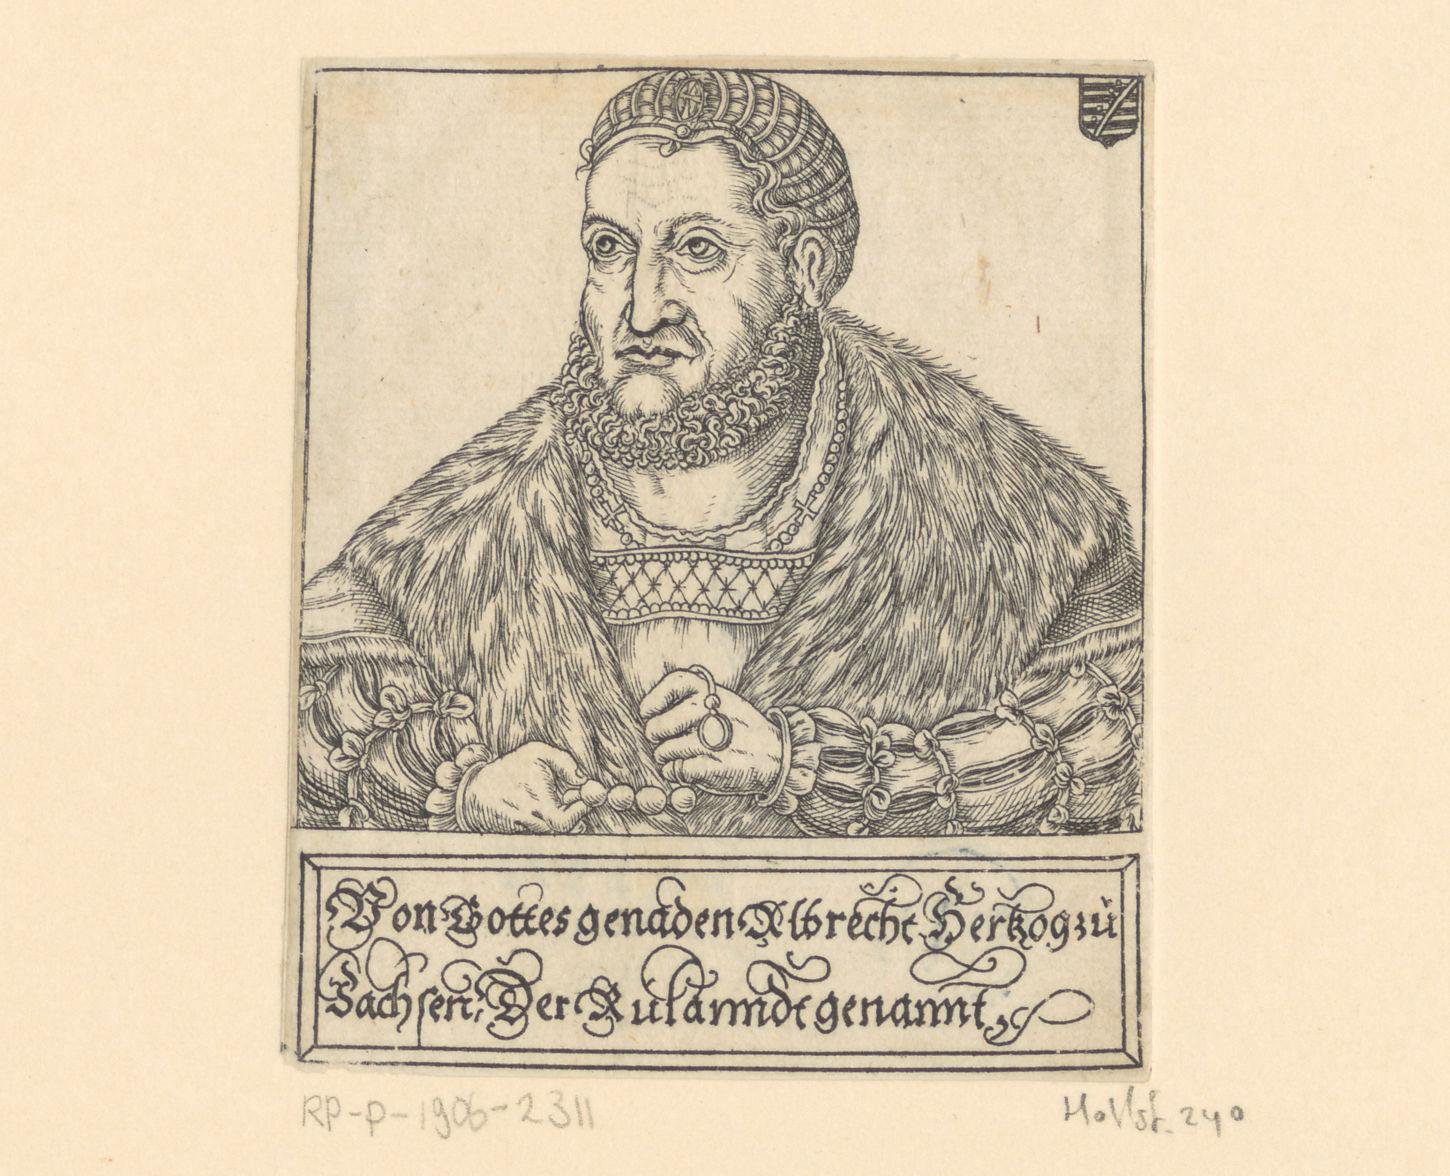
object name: print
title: Portret van Albrecht III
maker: balthasar jenichen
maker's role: draughtsman, goldsmith, print maker, printer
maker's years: -1621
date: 1563-1593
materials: paper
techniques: etching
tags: historical persons, ruler, sovereign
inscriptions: collector's mark: Lugt 2483, collector's mark: Lugt 2529, collector's mark: Lugt 2228